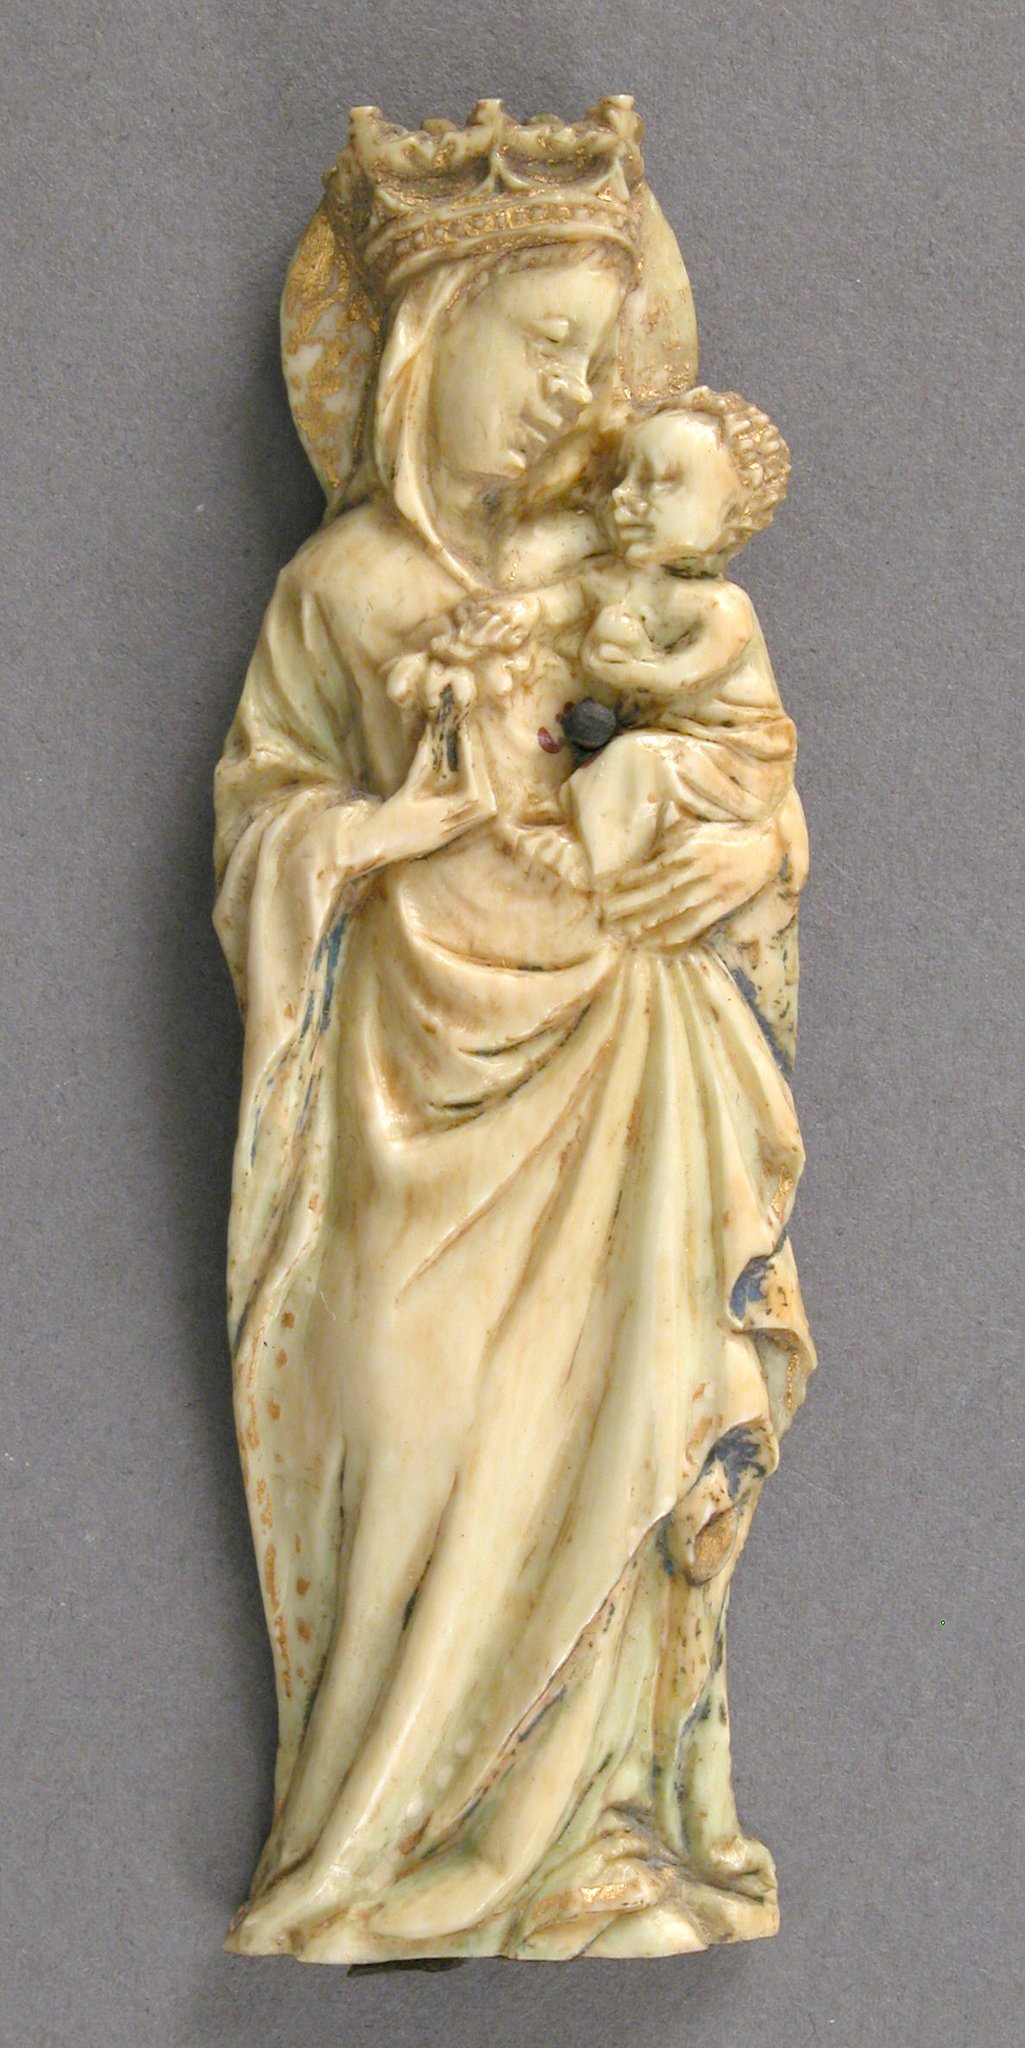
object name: plaque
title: Plaque with the Virgin and Child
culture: french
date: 1400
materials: ivory, paint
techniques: gilding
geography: france